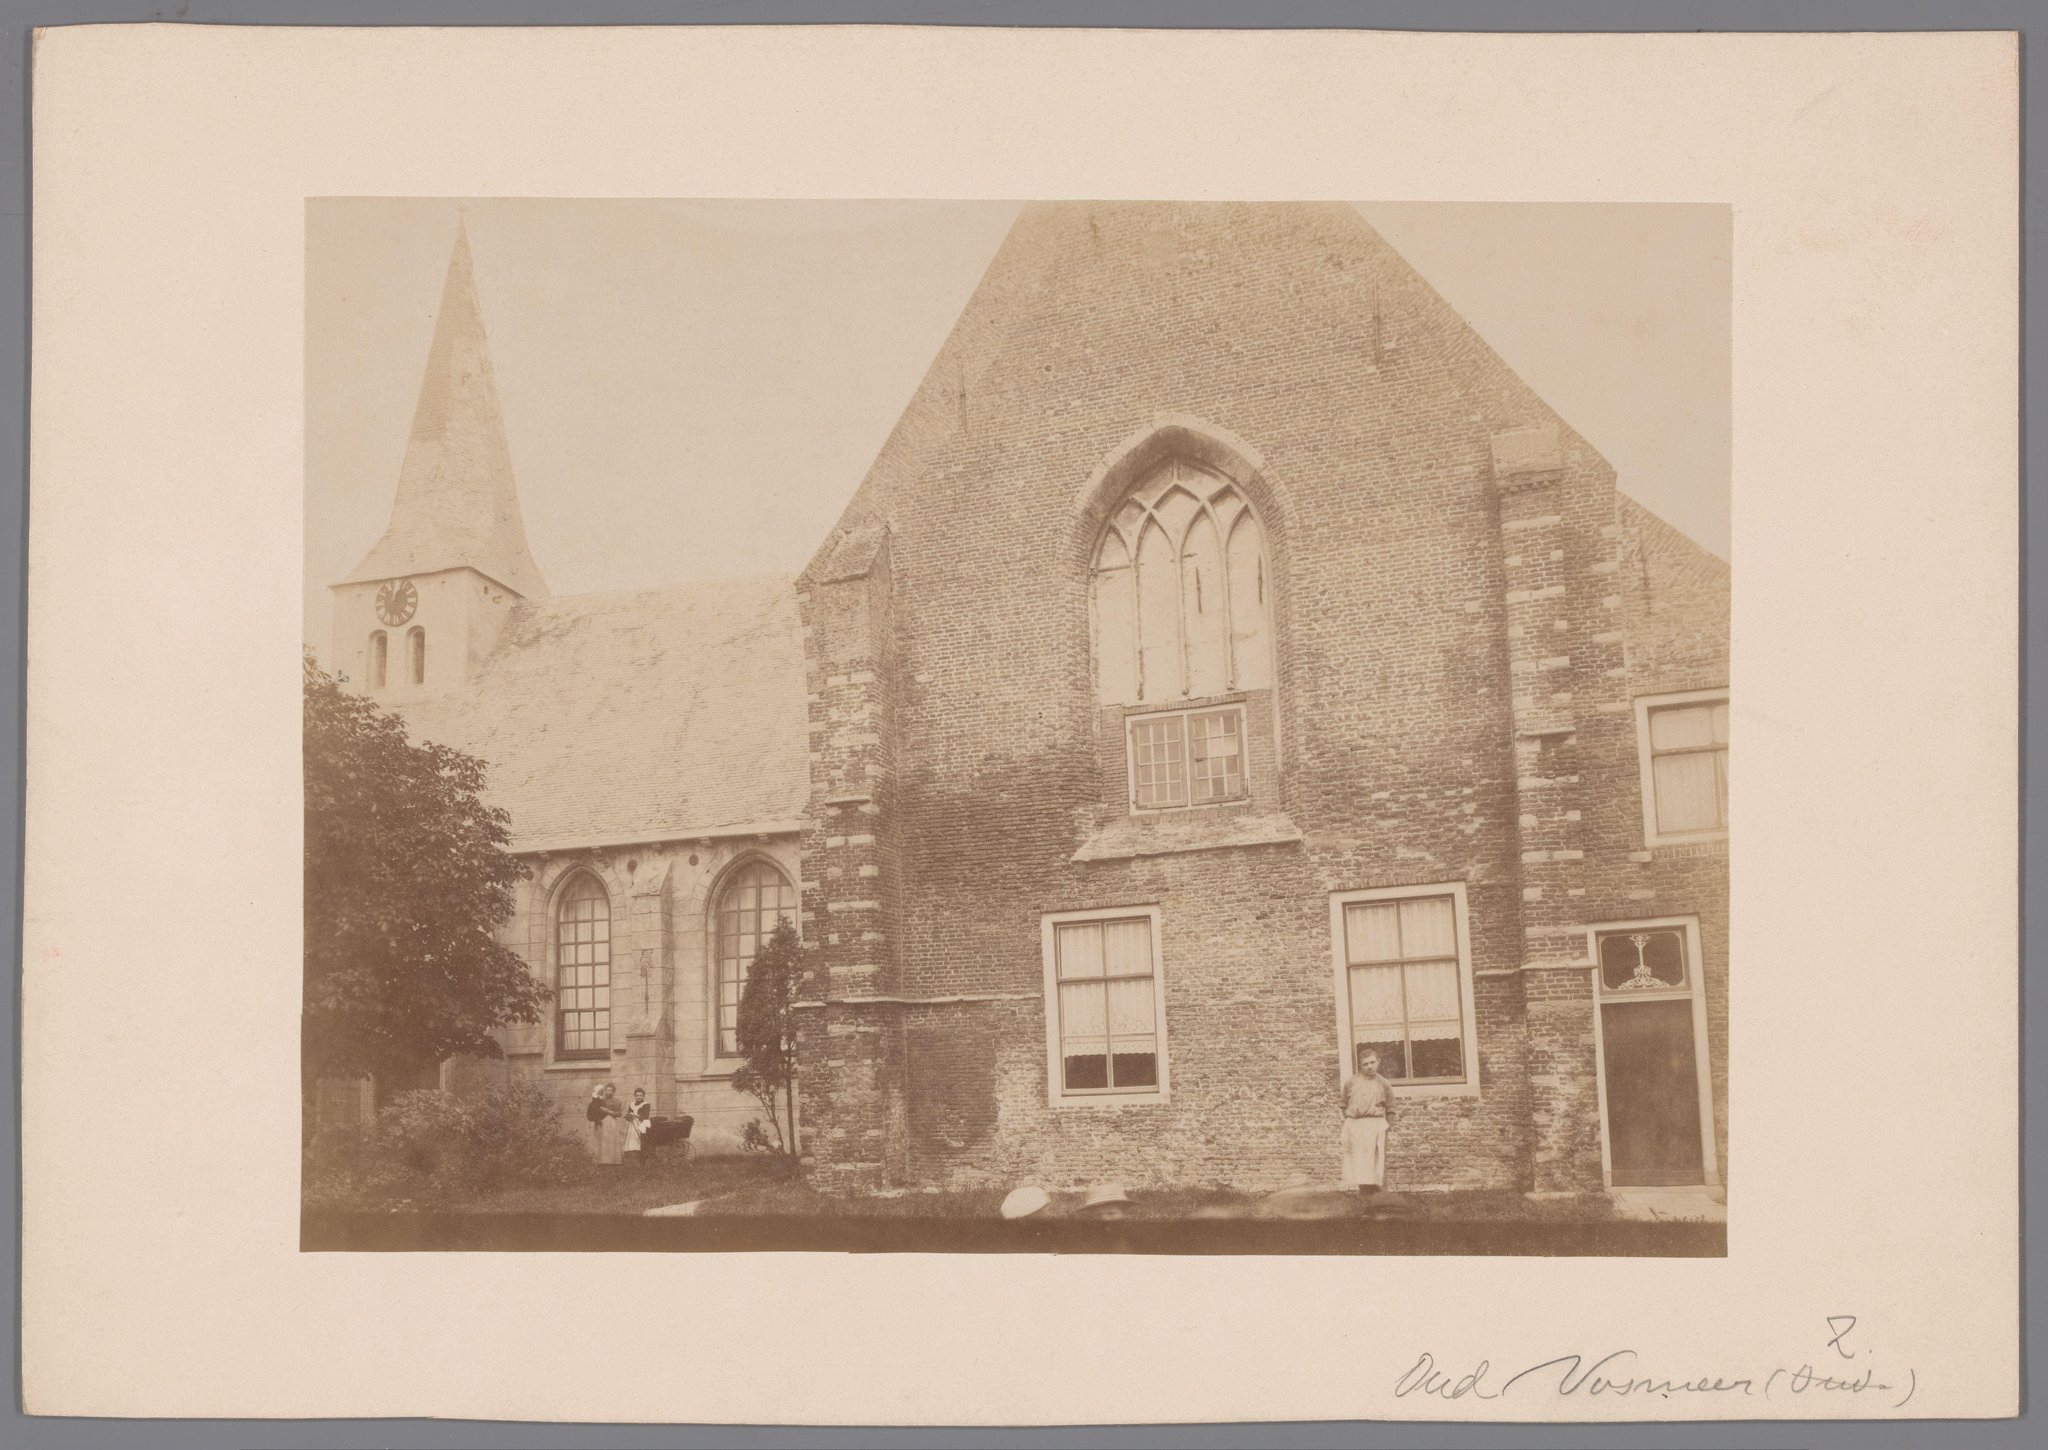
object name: photograph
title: Gezicht op de Hervormde Kerk te Oud-Vossemeer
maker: anoniem (monumentenzorg)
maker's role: fotograaf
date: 1901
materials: cardboard, photographic support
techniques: albumen print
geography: oud-vossemeer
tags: church (exterior)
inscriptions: annotation: ‘Oud Vosmeer Zeeland (Z)/ sept 1901’, annotation: ‘Oud Vosmeer (Z.)’